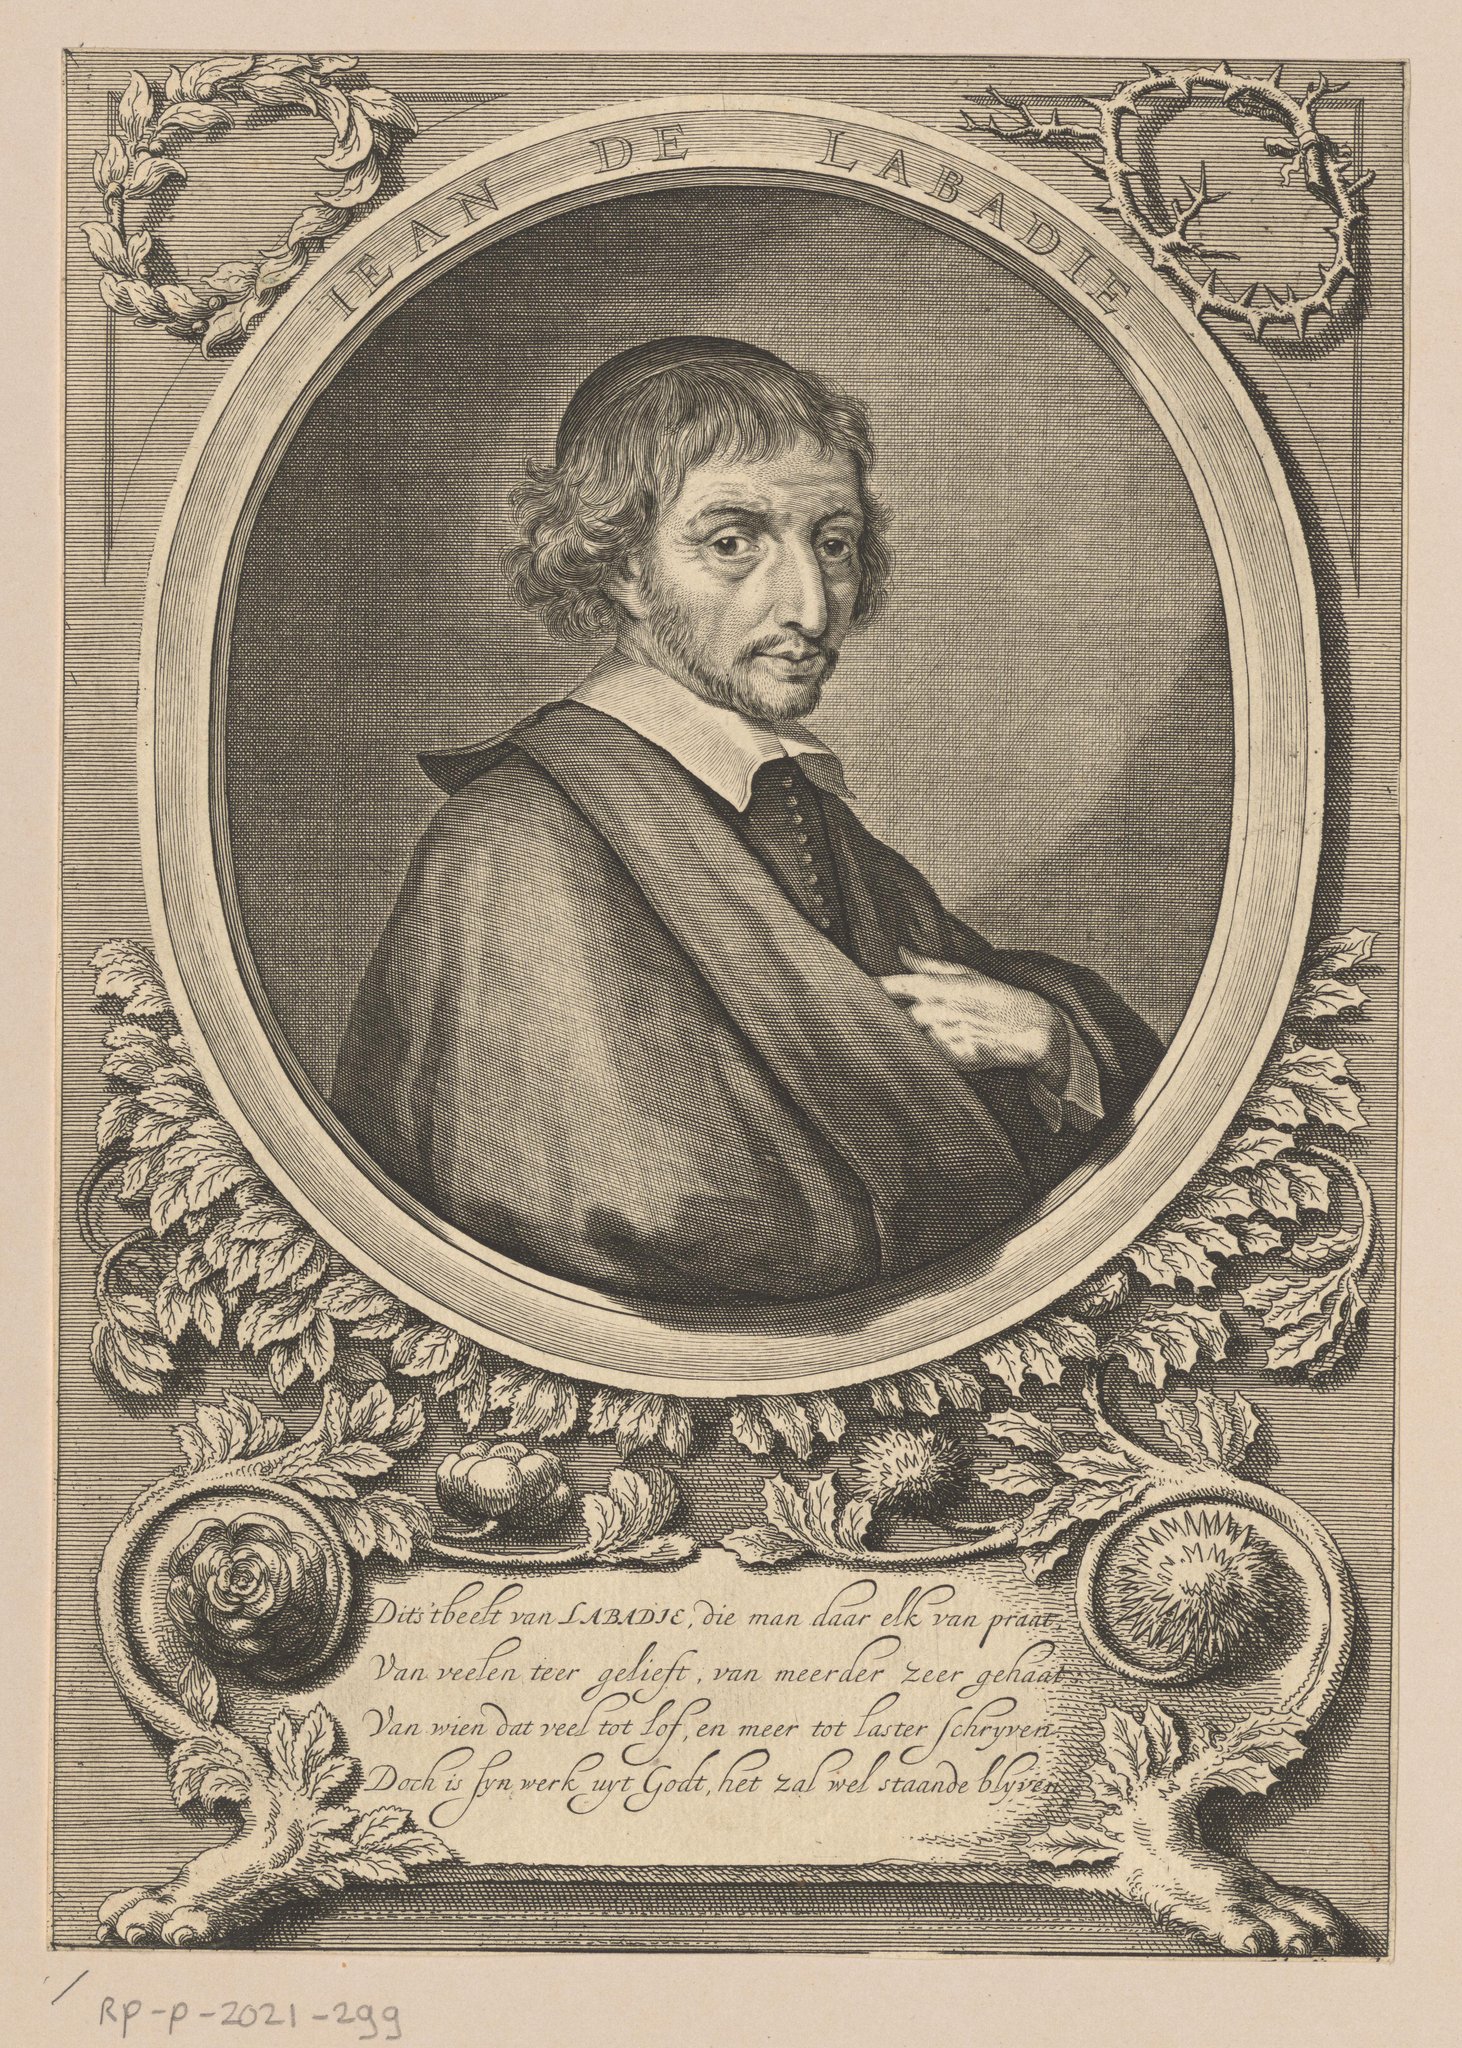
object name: print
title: Portret van Jean de Labadie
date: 1665-1706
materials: paper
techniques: engraving, etching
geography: amsterdam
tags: historical persons, crown of thorns ~ instruments of the passion, flowers: rose, plants and herbs: thistle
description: Rond het portret een ornamentele omlijsting met in de linkerbovenhoek een lauwerkrans en in de rechterbovenhoek een doornenkroon. Linksonder een roos en rechtsonder een distel met daartussen een cartouche met vierregelig vers in het Nederlands.